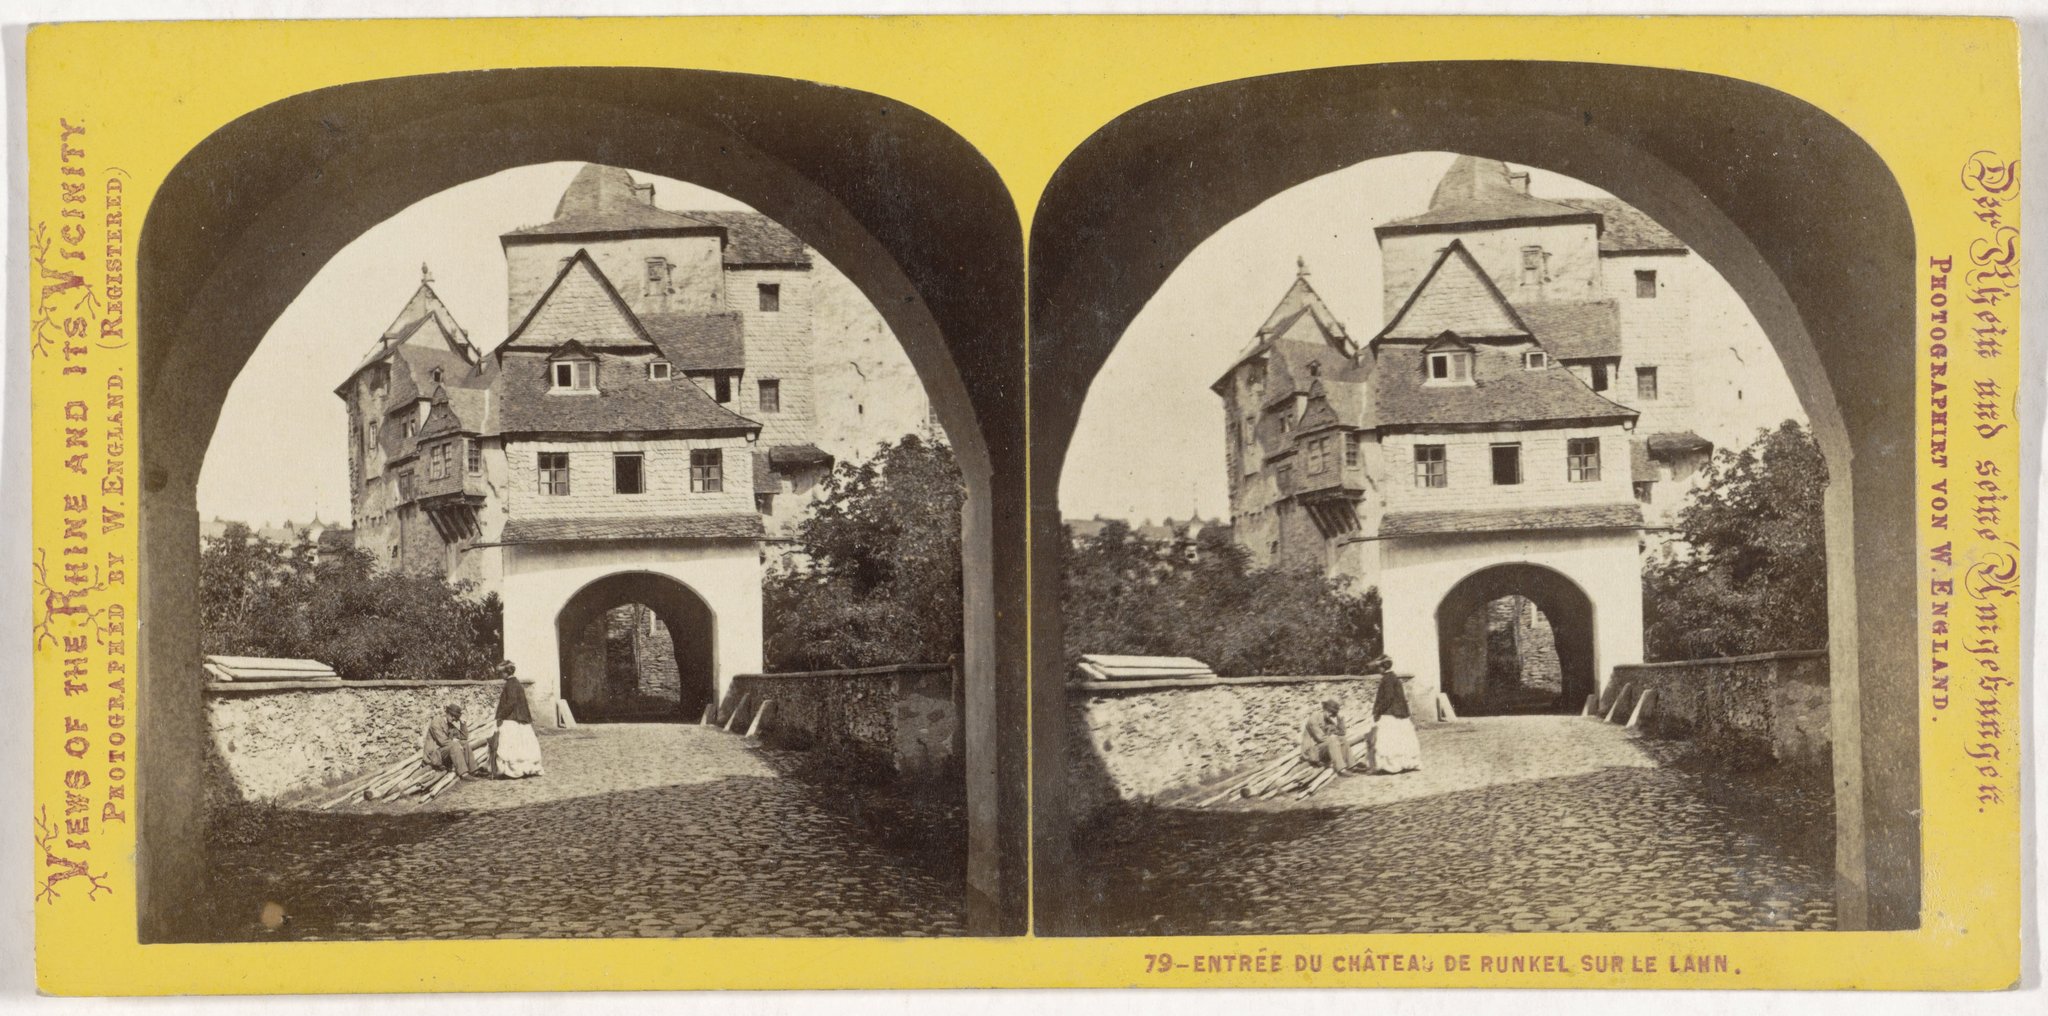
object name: stereograph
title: Entrée du Château de Runkel sur le Lahn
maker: william england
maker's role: fotograaf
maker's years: 1816-1896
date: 1867-1868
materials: cardboard, paper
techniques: albumen print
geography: runkel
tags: gate ~ fortified city, castle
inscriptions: number: ‘79’, inscription: ‘(Registered)’